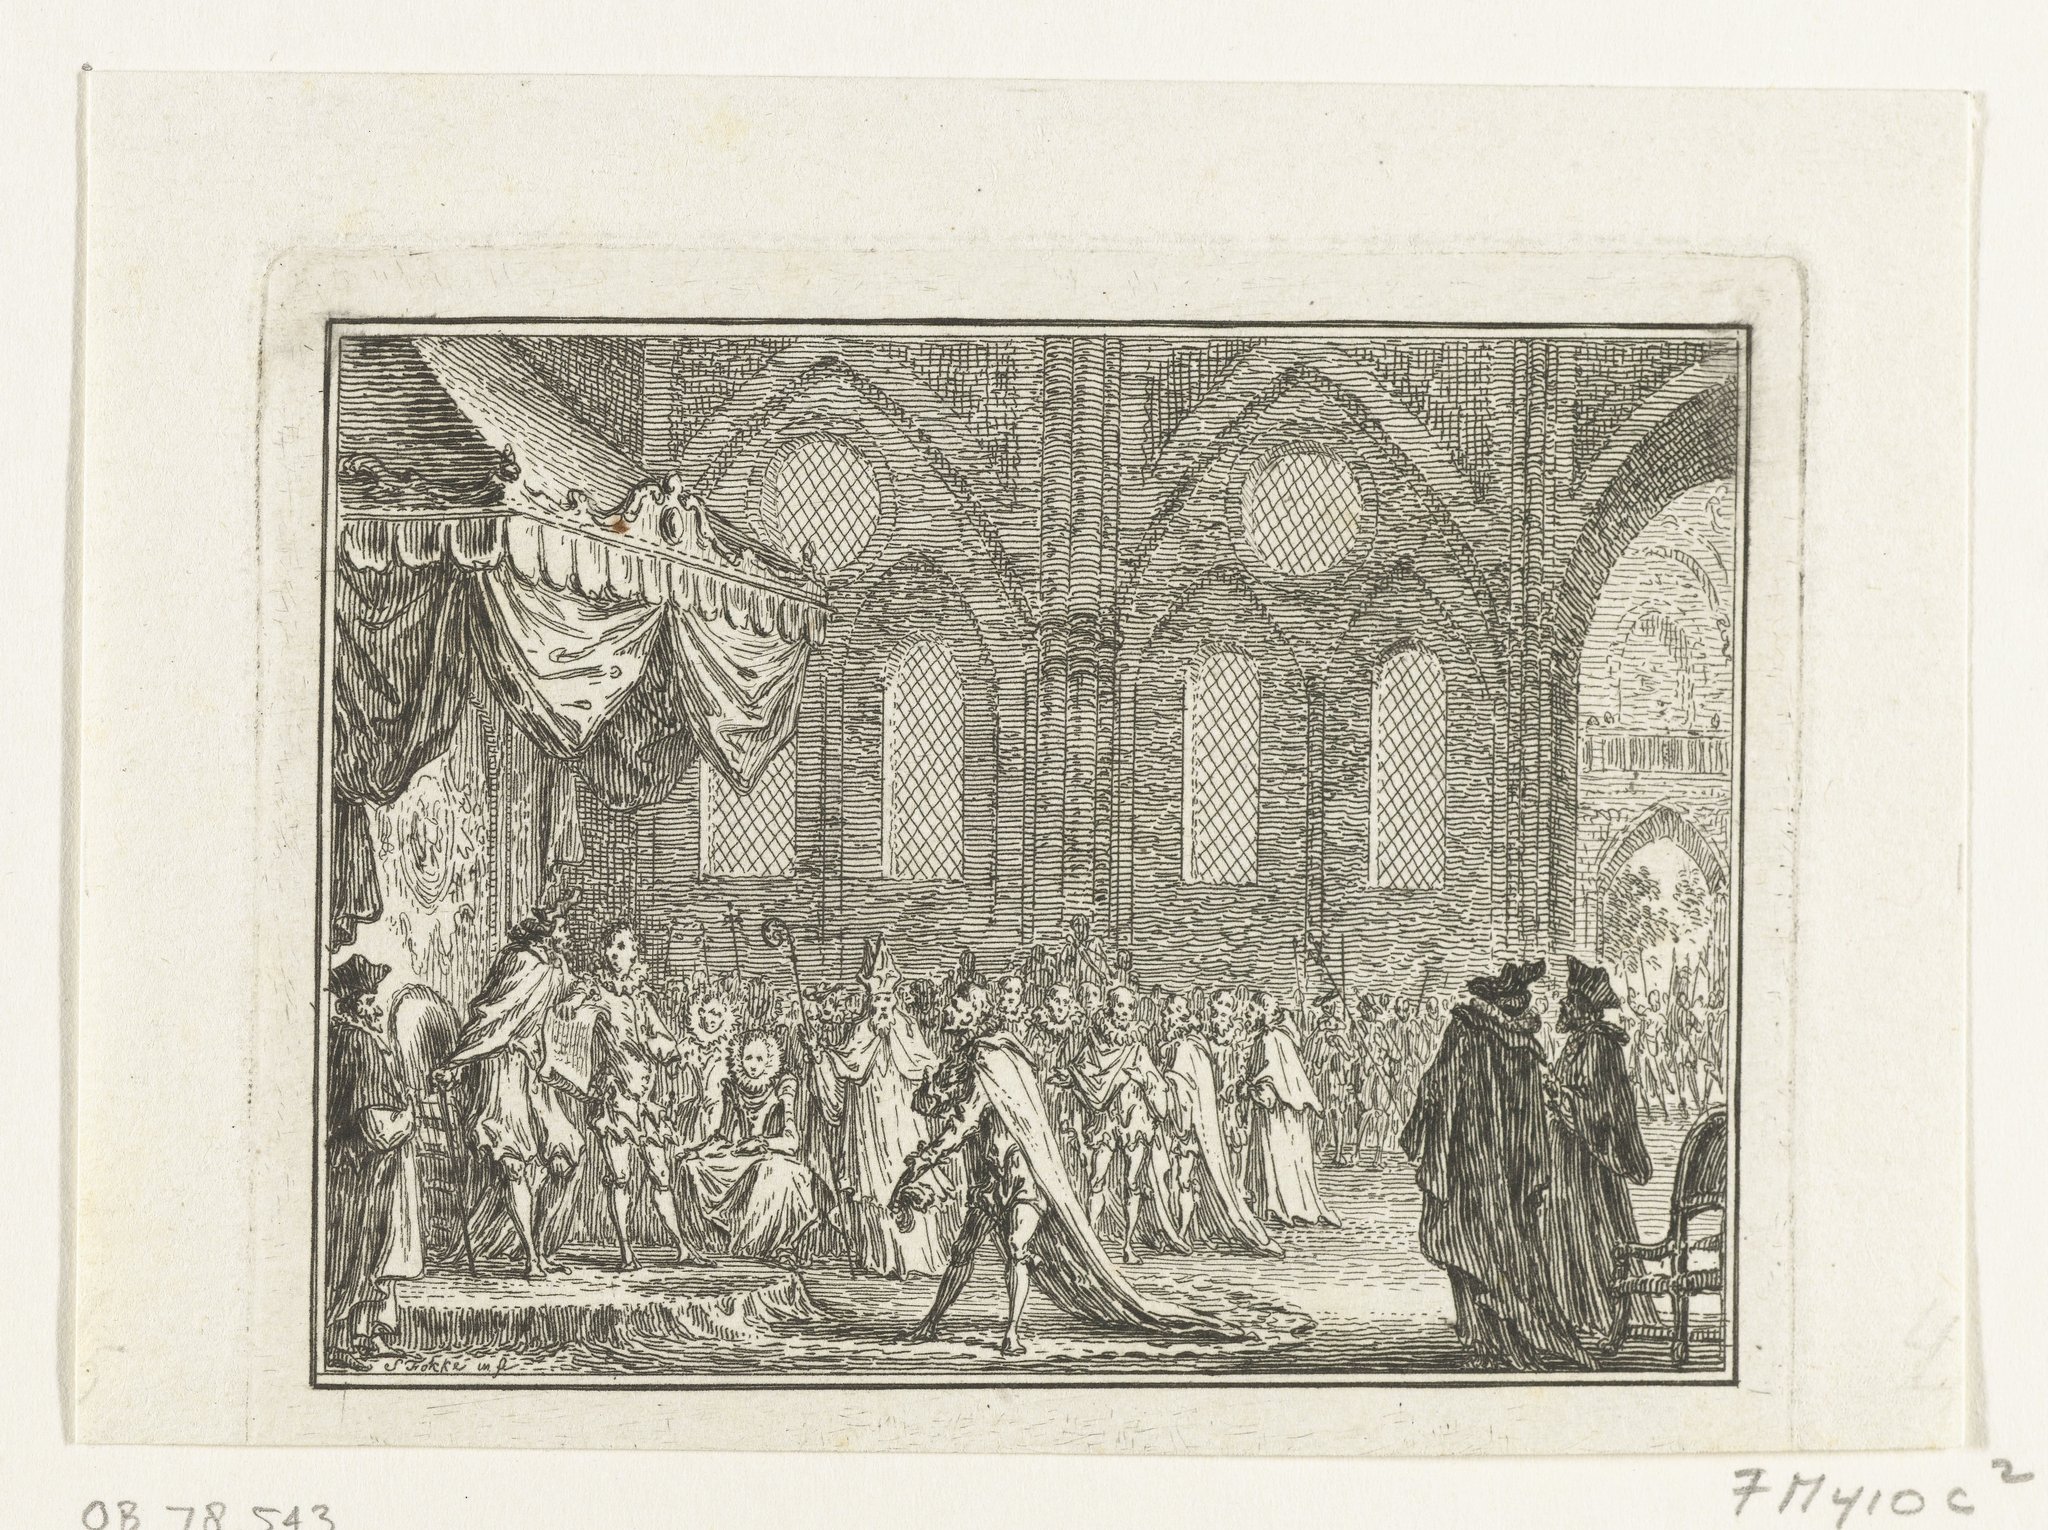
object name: print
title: Troonsafstand van keizer Karel V, 1555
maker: simon fokke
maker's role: draughtsman, print maker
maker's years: 1712-1784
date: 1782-1784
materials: paper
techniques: etching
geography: northern netherlands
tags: philip ii of spain, delft, william i (prince of orange), ghent, charles v (holy roman emperor and king of spain), voluntary abdication (of a ruler)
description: Illustratie voor:J.W. te Water, De vaderlandsche Historie van den heere J. Wagenaar, verkort, en met leerzaame aanmerkingen, ten dienste der Nederlandsche jeugd, 1784-1800, 4 delen. Staat vóór de letter. Niet in Frederik Muller; door het RPK toegevoegd nummer.